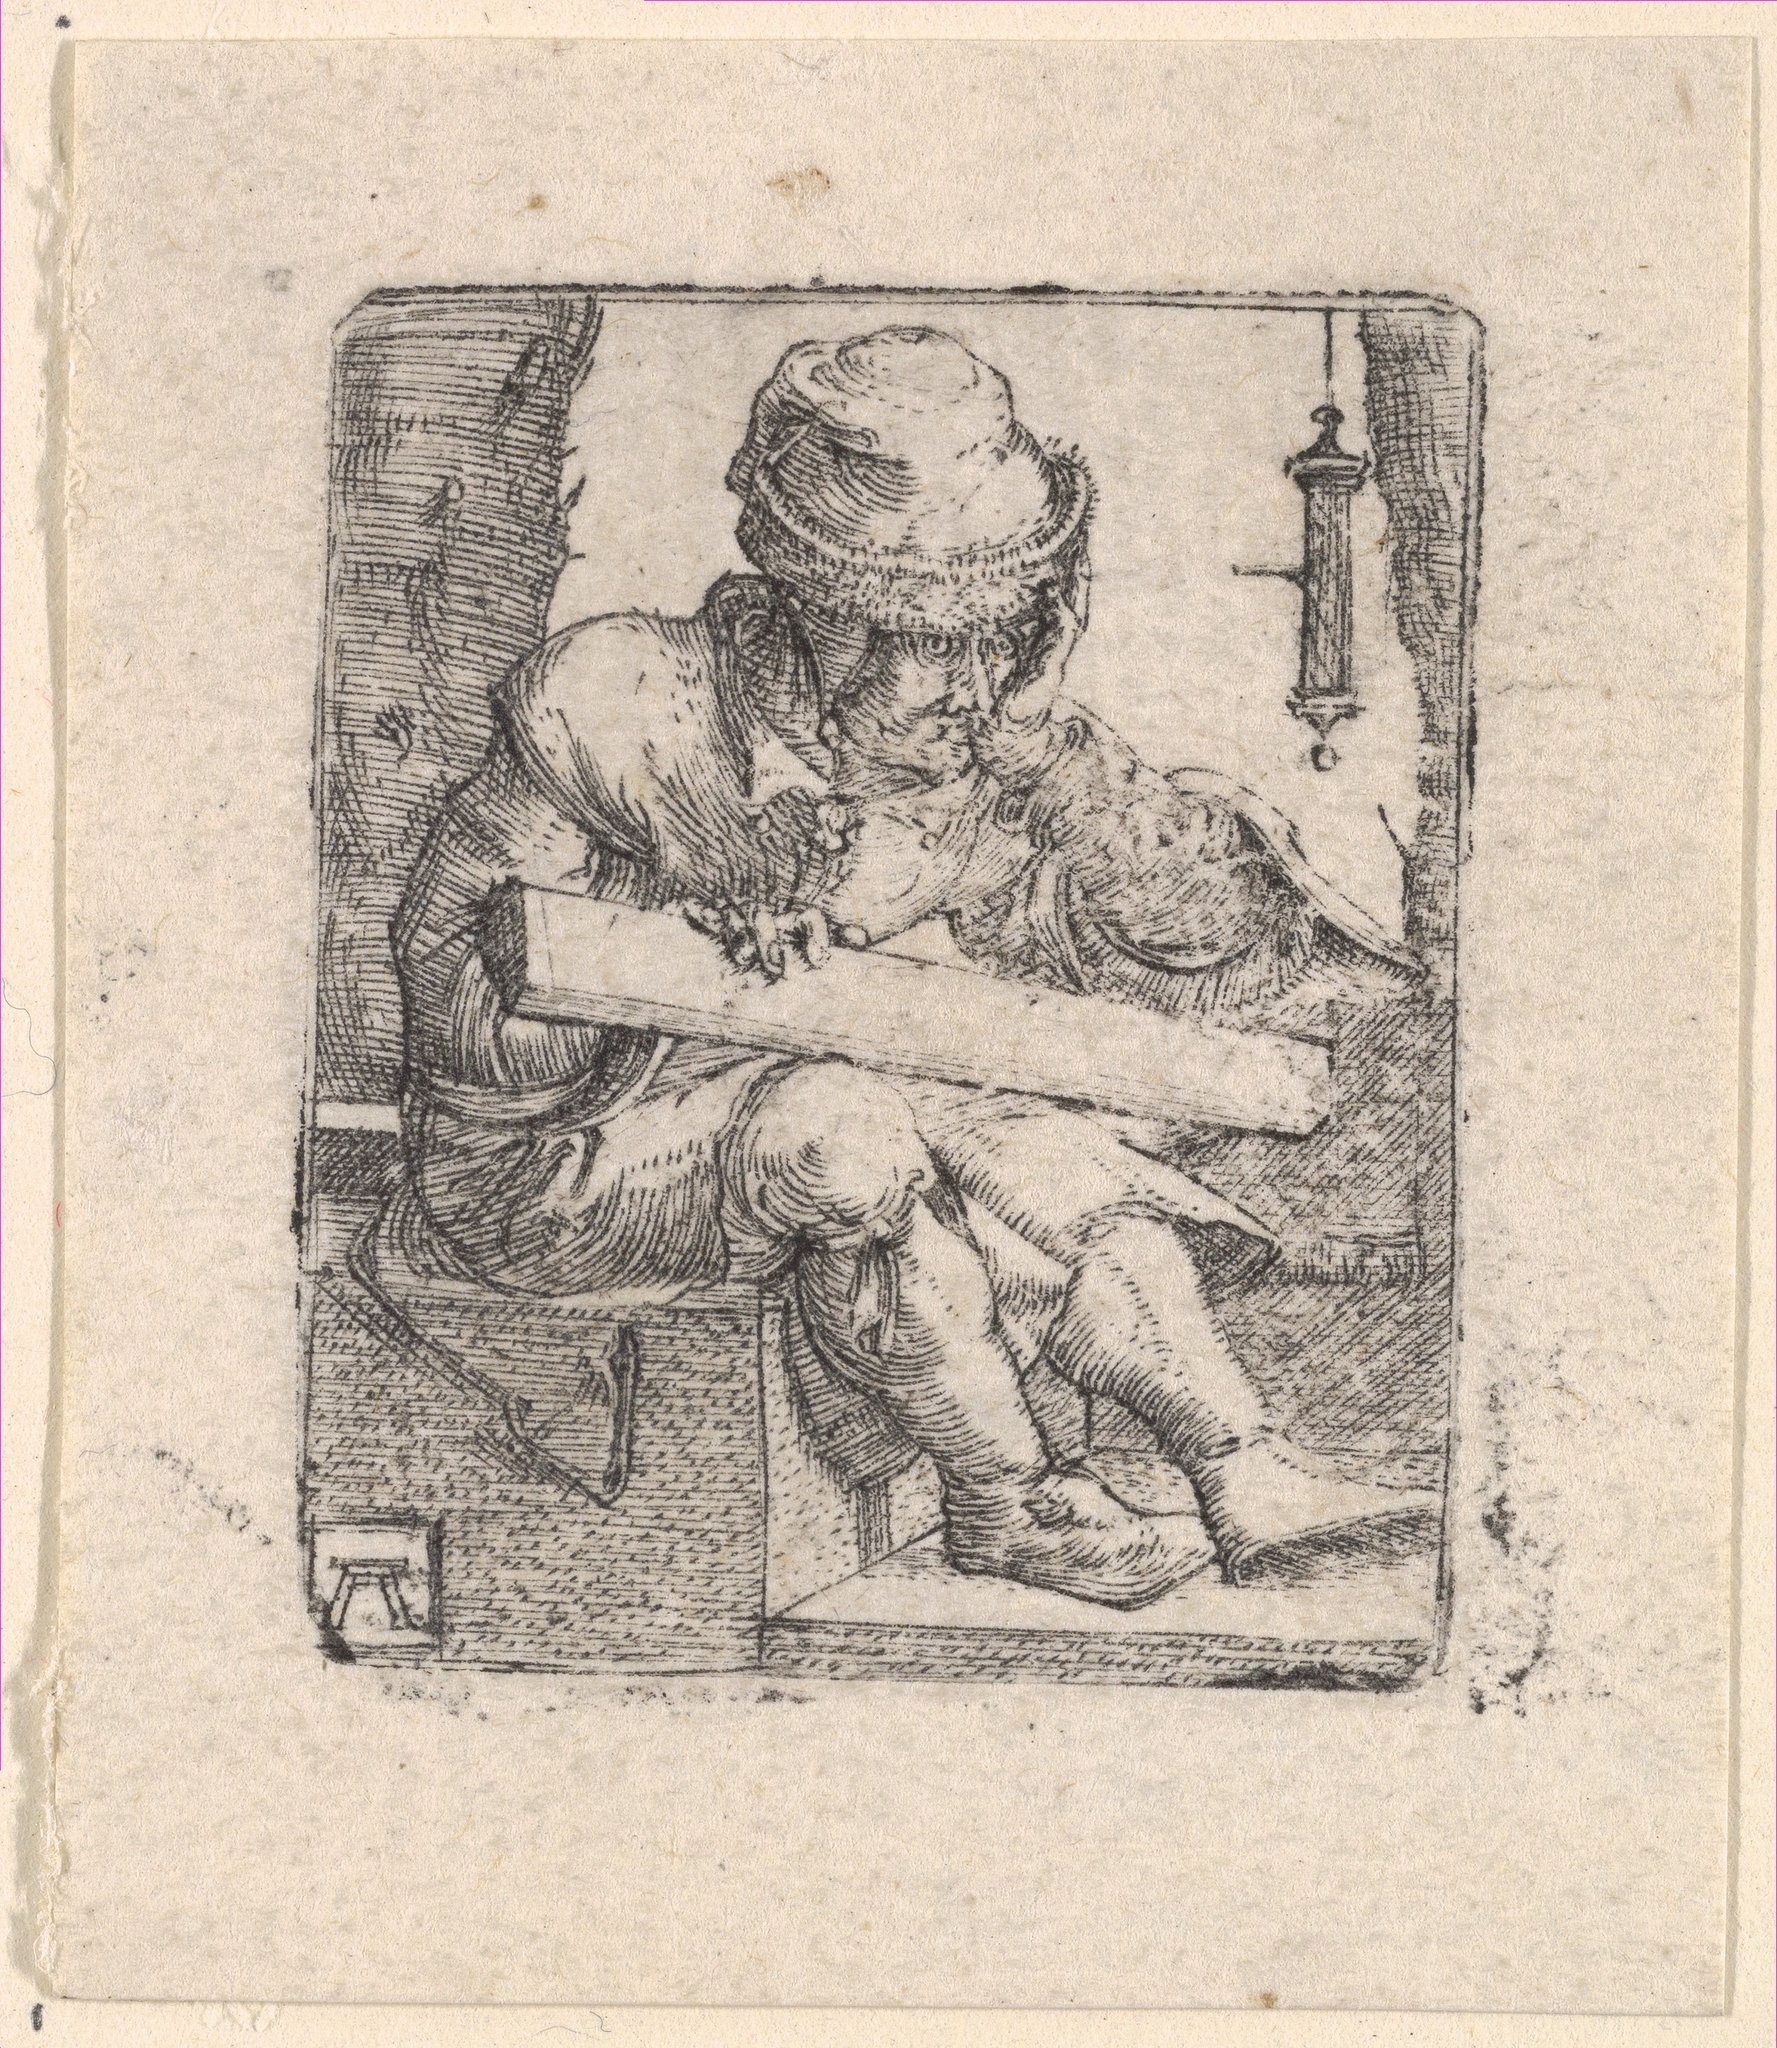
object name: print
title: Carpenter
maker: albrecht altdorfer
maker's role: artist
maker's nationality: german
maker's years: 1480-1538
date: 1520-1530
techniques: engraving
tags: men